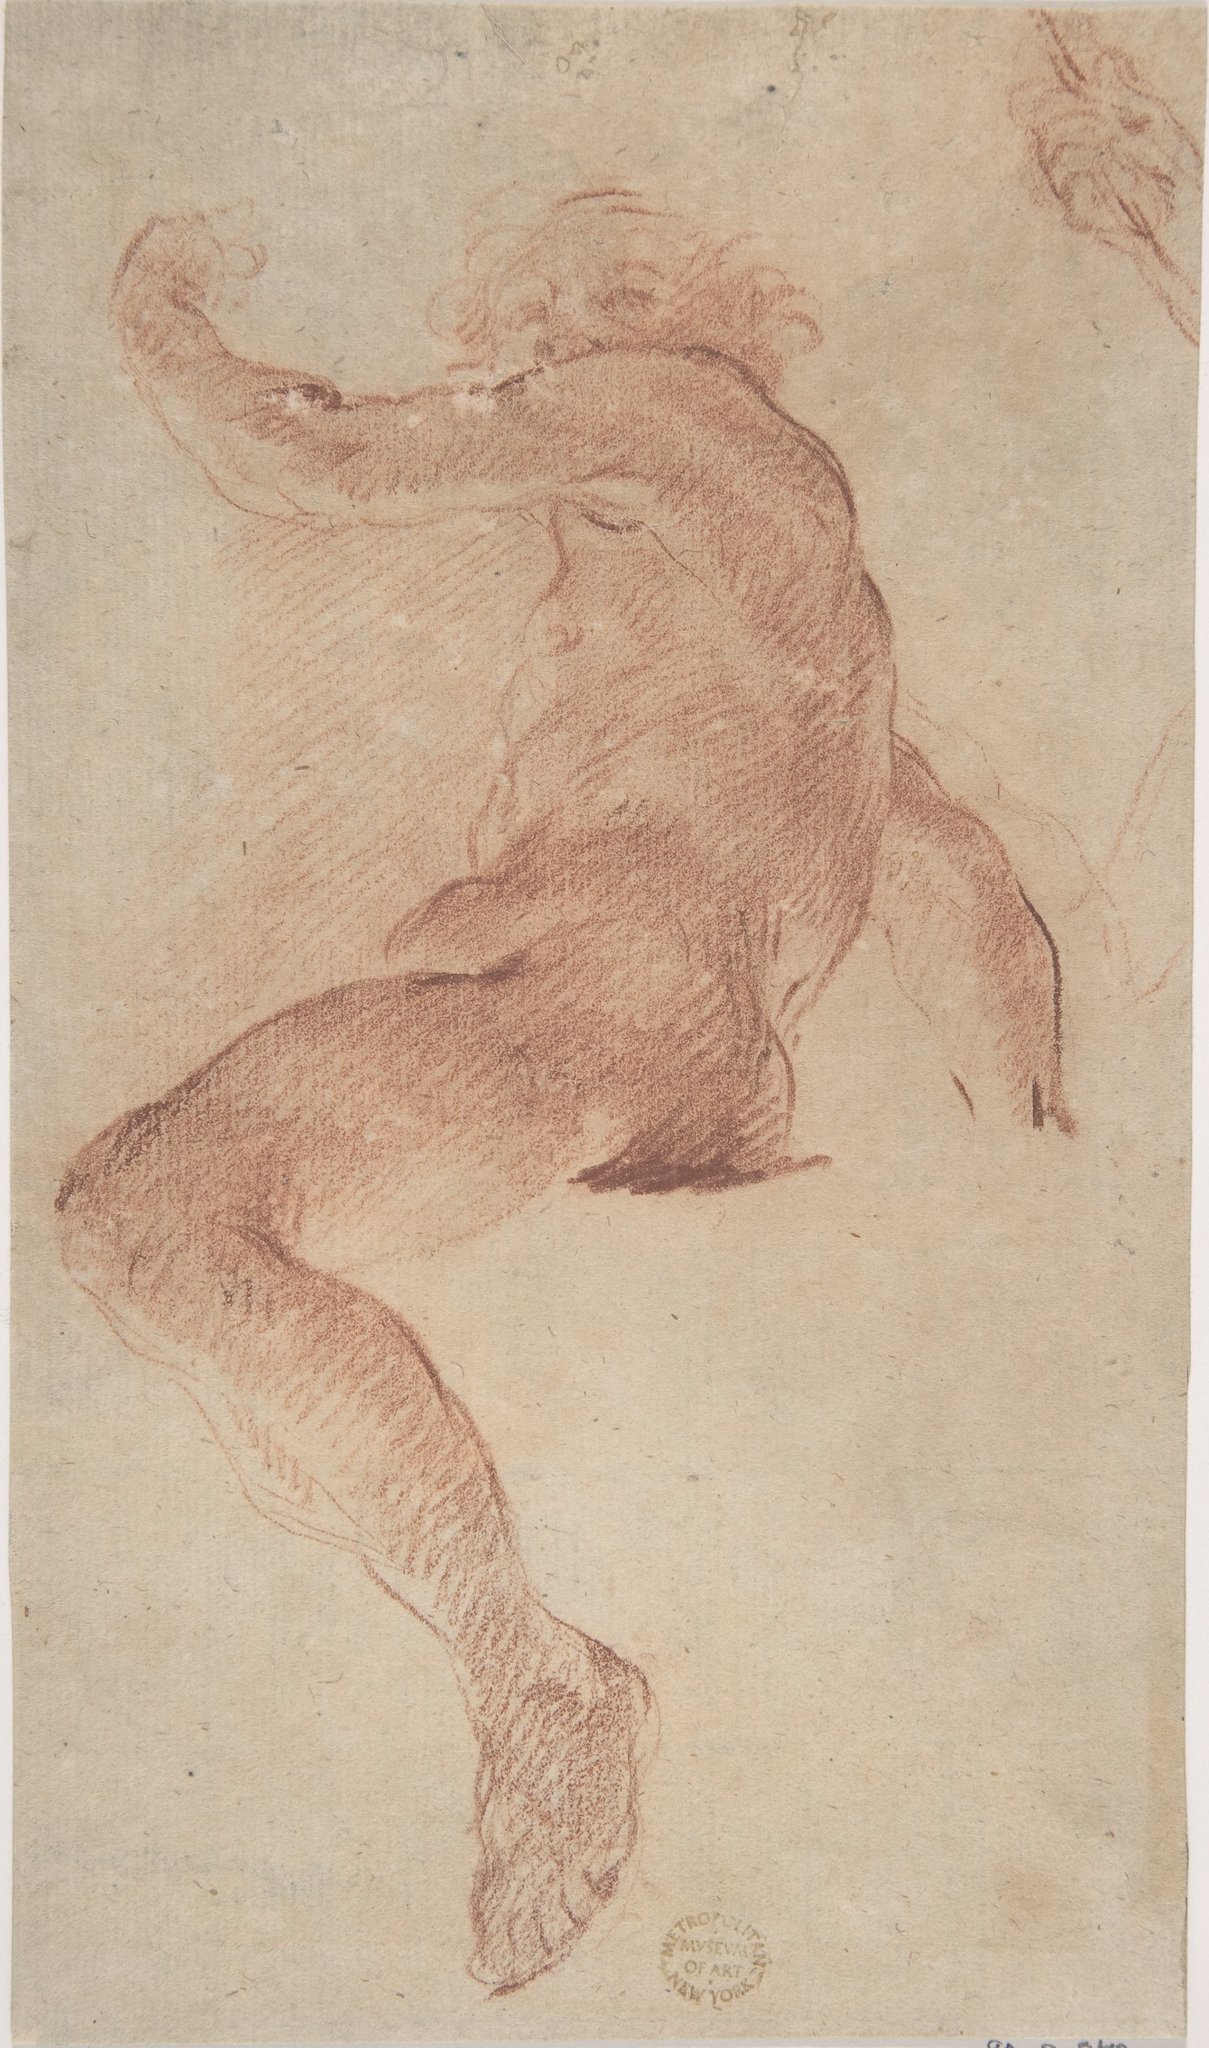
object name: drawing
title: Seated Nude Male in Profile View Facing Left with Arm Raised; Fragment of Study of Right Hand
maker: anonymous, italian, bolognese, 17th century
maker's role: artist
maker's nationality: italian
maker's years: 1600-1700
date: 1601-1700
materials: chalk, crayon, paper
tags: male nudes